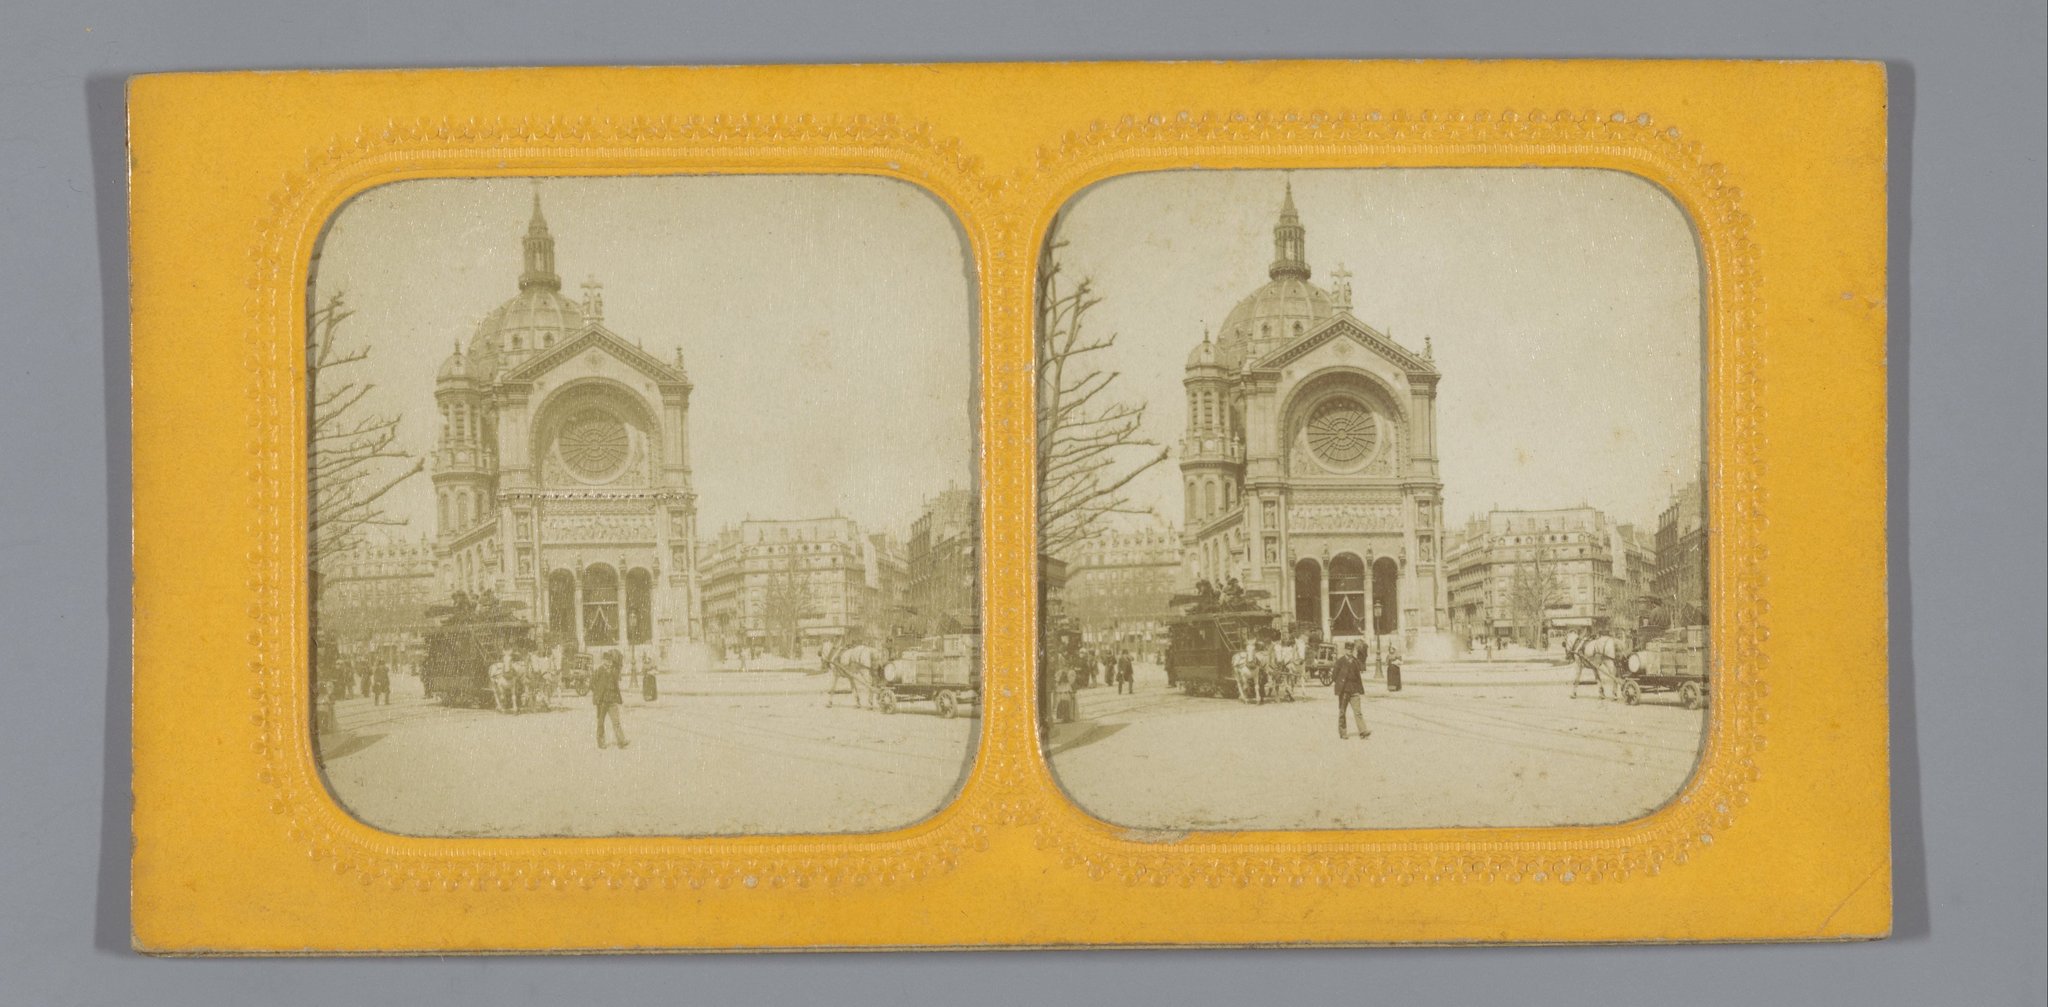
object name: tissue stereograph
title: St. Augustin, Paris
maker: Anonymous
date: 1855-1875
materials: cardboard, paper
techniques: albumen print, hand coloring, perforating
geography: paris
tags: church-window, e.g. rose-window, church (exterior)